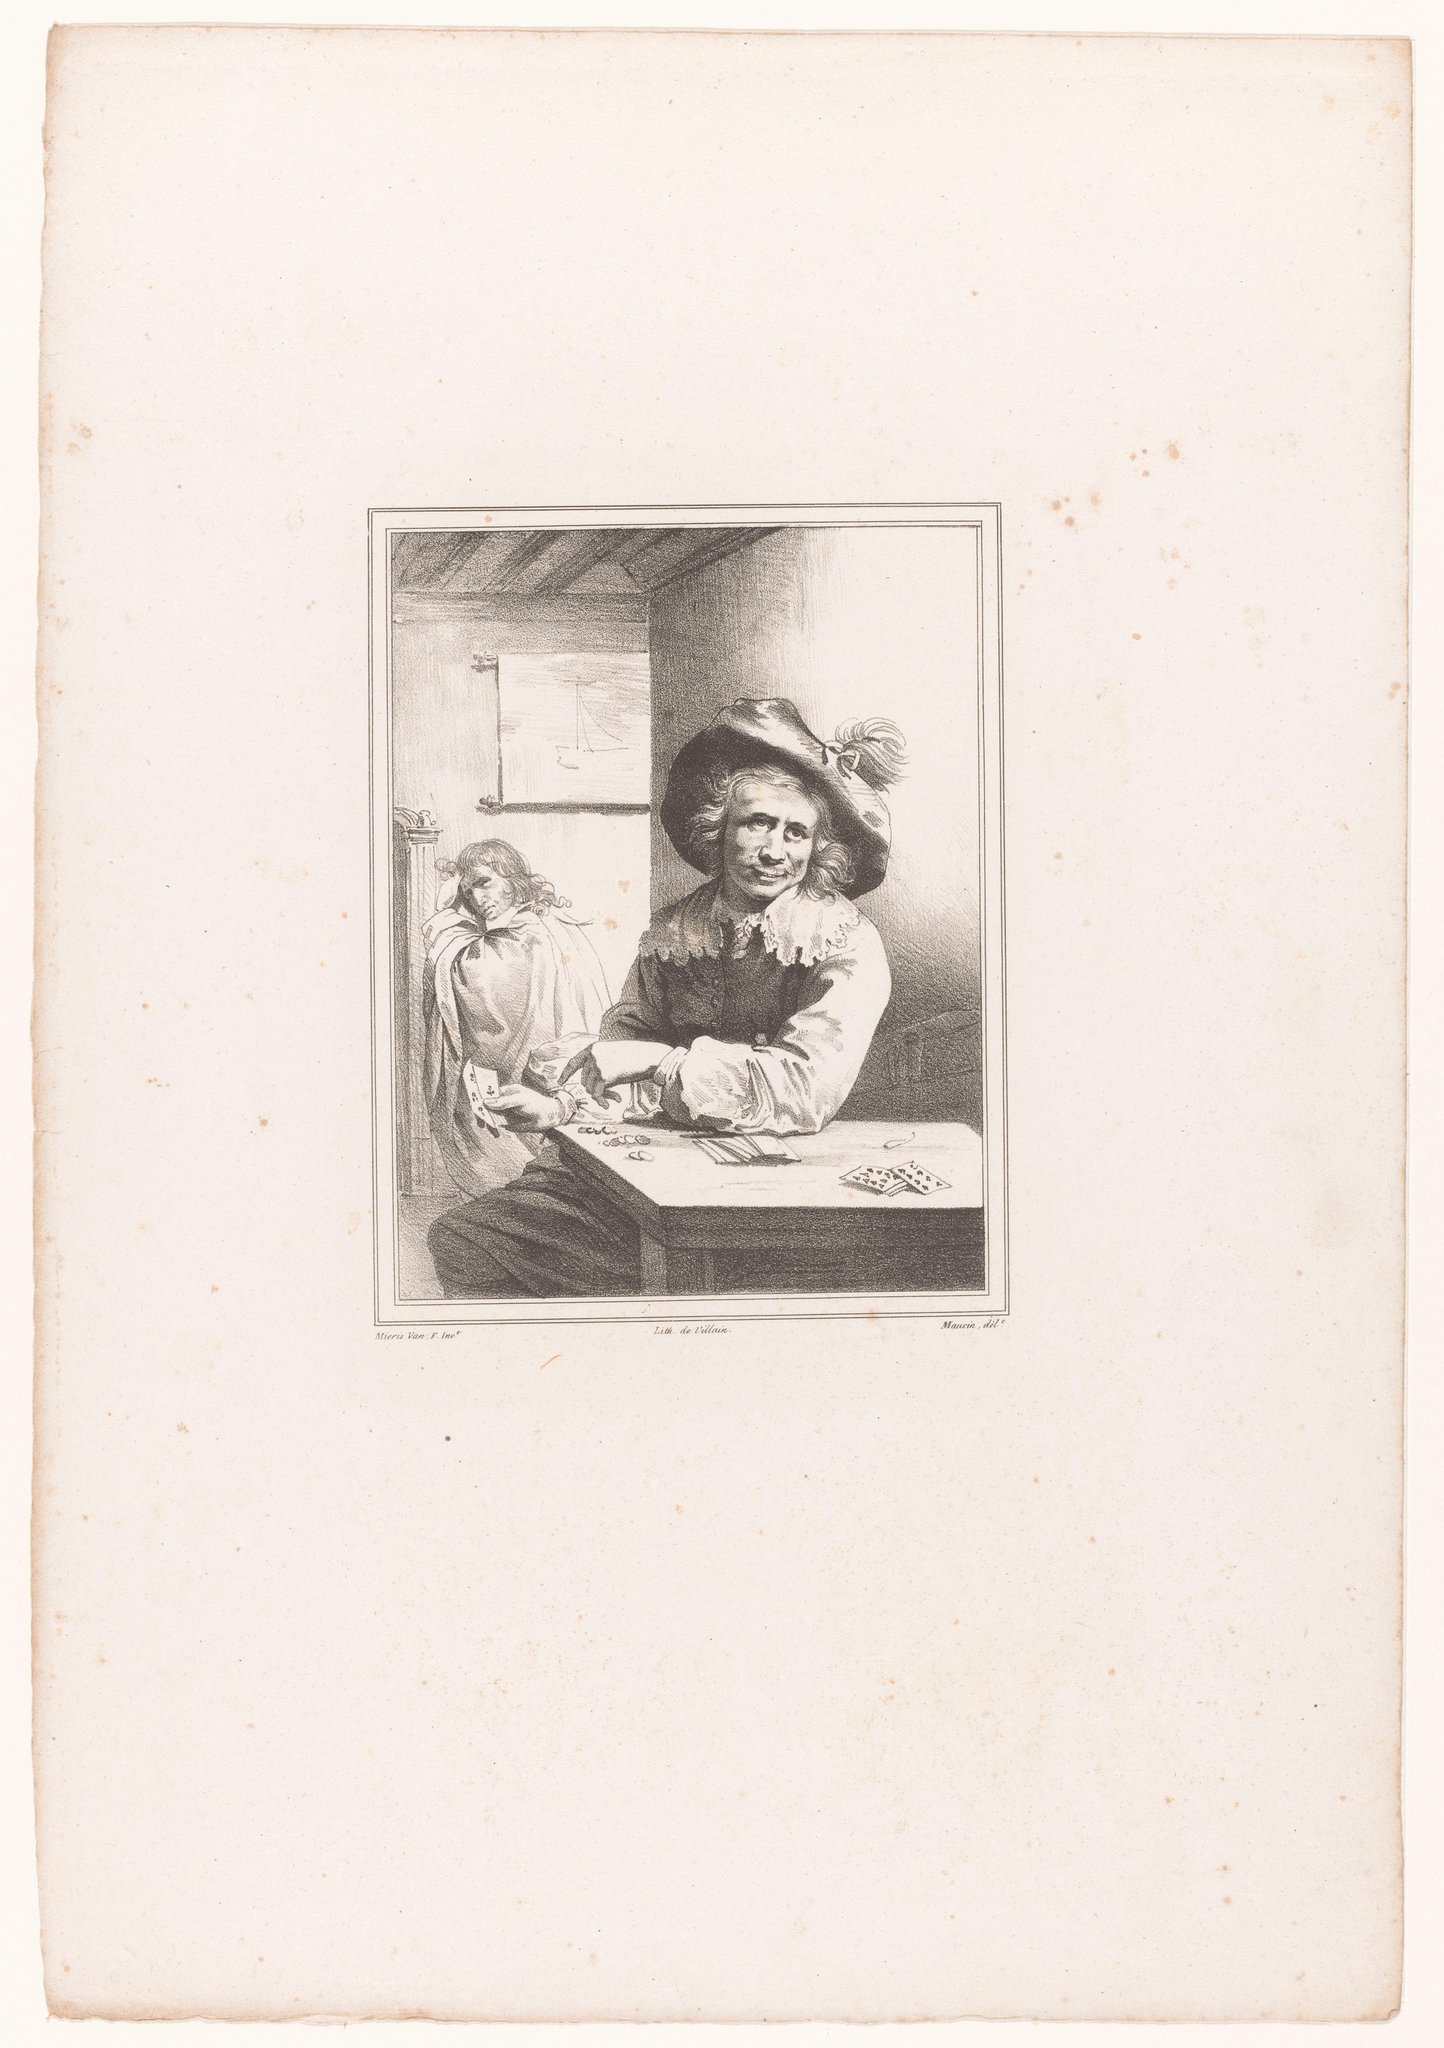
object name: print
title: Kaartspelers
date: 1825-1852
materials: paper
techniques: lithograph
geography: paris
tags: historical persons, games of calculation and chance, e.g.: card games, gambling, puzzles, etc., painting (including book-illumination, miniature-painting)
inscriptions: collector's mark: Lugt 2233, check stamp: ‘JC’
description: Prent ook gebruikt in: Chabert, Jean Claude. Galerie des peintres ou collection de portraits des peintres les plus célèbres de toutes les écoles. Accompagnée d'une notice sur chacun d'eux, et de copies de dessins originaux / Galerie des peintres ou collection de portraits des peintres les plus célèbres de toutes les écoles. Accompagnée de leur notice historique, de leurs dessins et d'un discours sur les arts. Parijs: Jean Claude Chabert, s.a. [1822-1834]. De samenstelling van tegenwoordig bekende en al dan niet gebonden exemplaren van deze uitgave verschillen. Dit omdat de prenten en bijhorende stukken tekst op inschrijving en waarschijnlijk ook los verkrijgbaar waren.